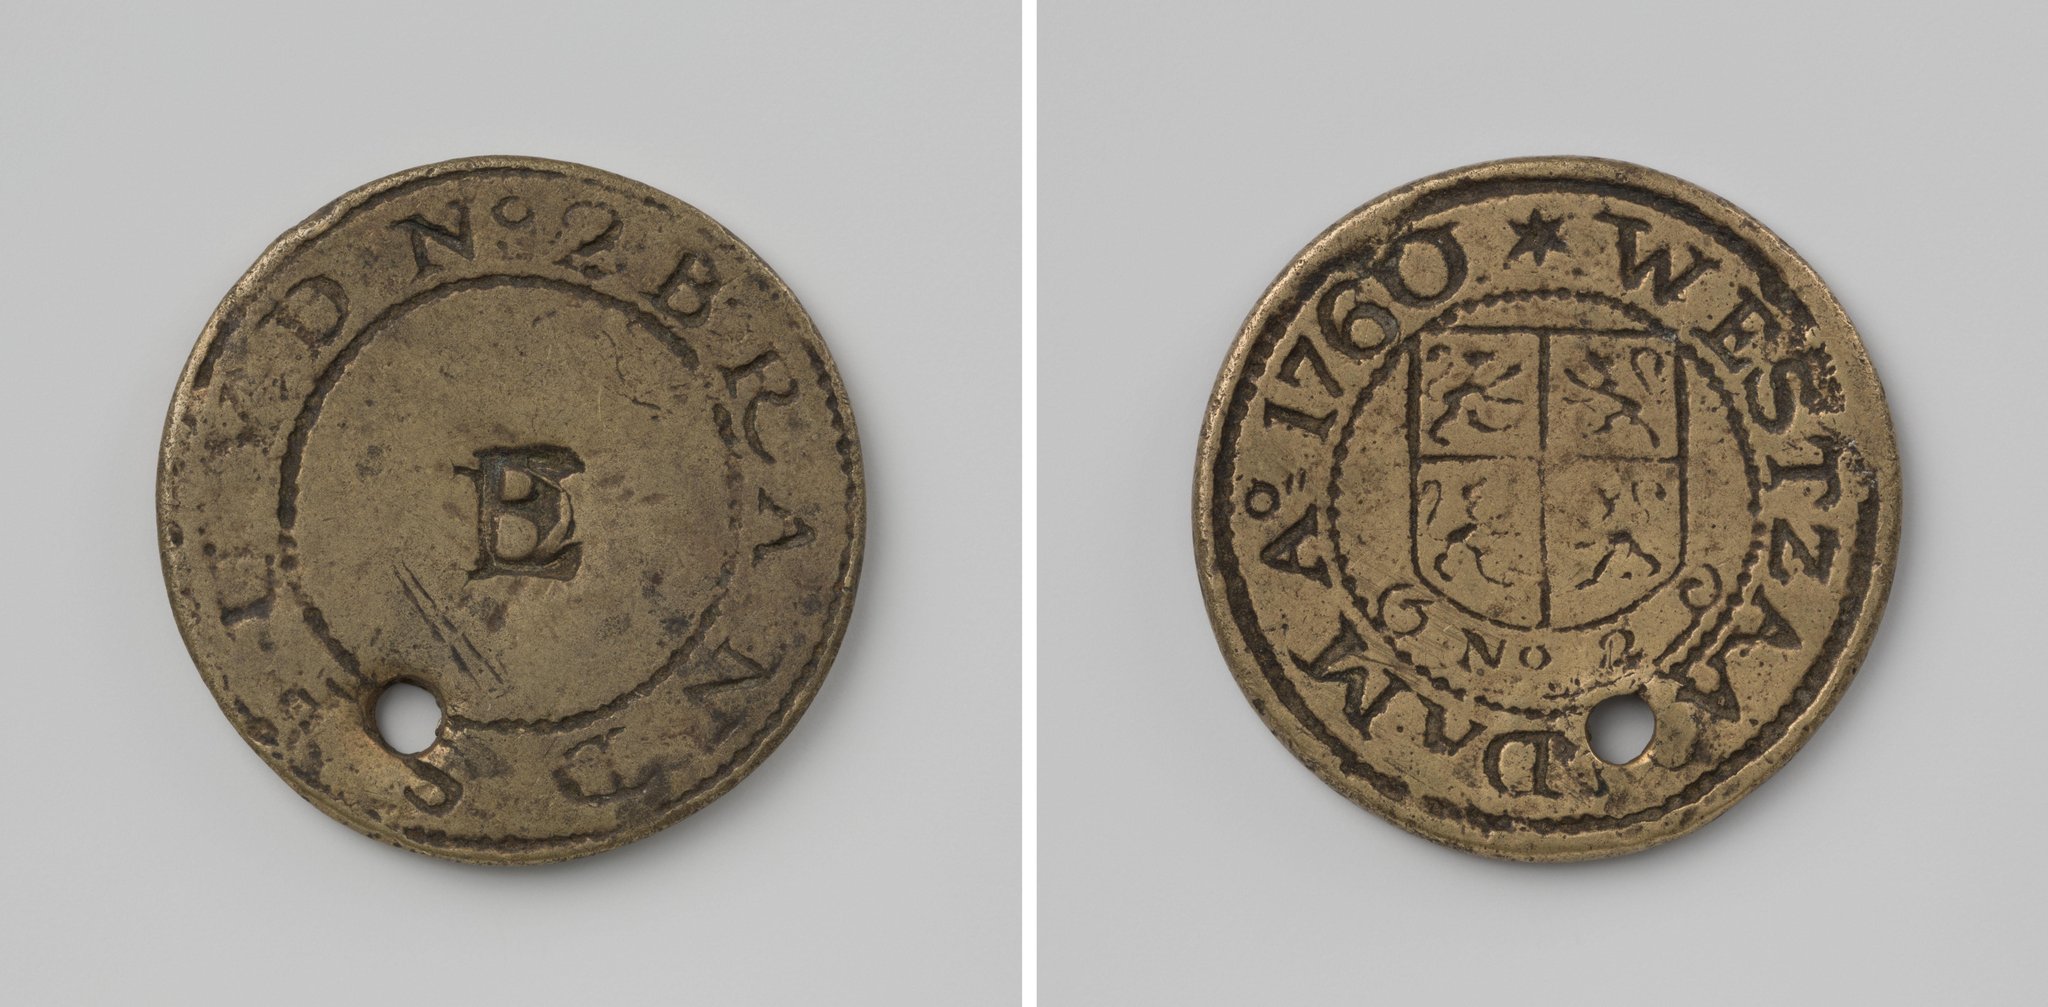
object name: fire engine medal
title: West Zaandam, brandspuitpenning van spuit 2 met onduidelijk monogram of cijfer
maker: Anonymous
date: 1760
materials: brass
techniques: engraving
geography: zaandam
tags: west zaandam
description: Messing penning met gat erin. Voorzijde: onduidelijk monogram, mogelijk letter E met andere letter of cijfer erdoor binnen omschrift. Keerzijde: wapenschild boven opschrift no. 2 binnen omschrift